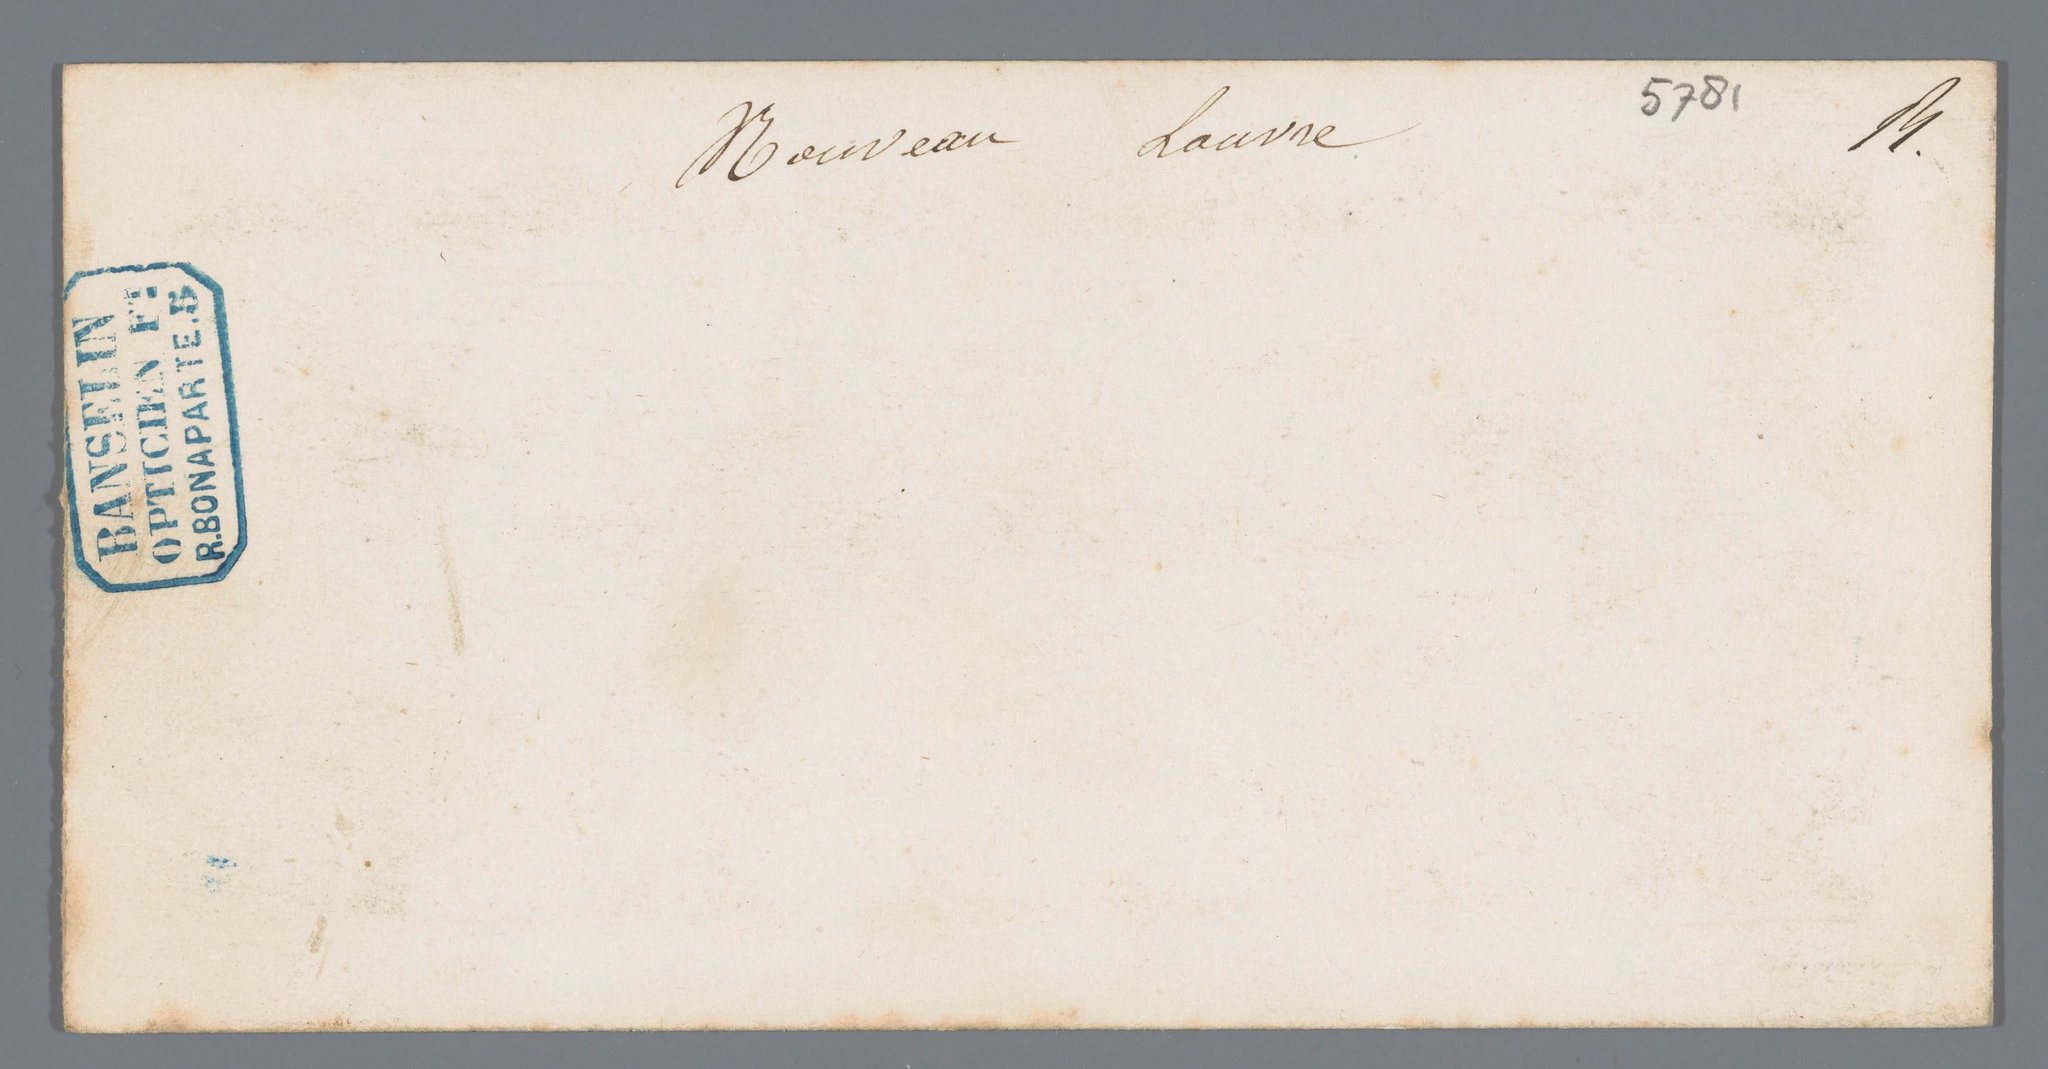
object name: stereograph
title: Gezicht op het Musée du Louvre in Parijs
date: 1850-1880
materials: cardboard, photographic support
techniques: albumen print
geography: paris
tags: permanent exhibition, museum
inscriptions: name: ‘Banselin Opticien Ft R.Bonaparte.5’, inscription: ‘Nouveau Louvre’, number: ‘14.’